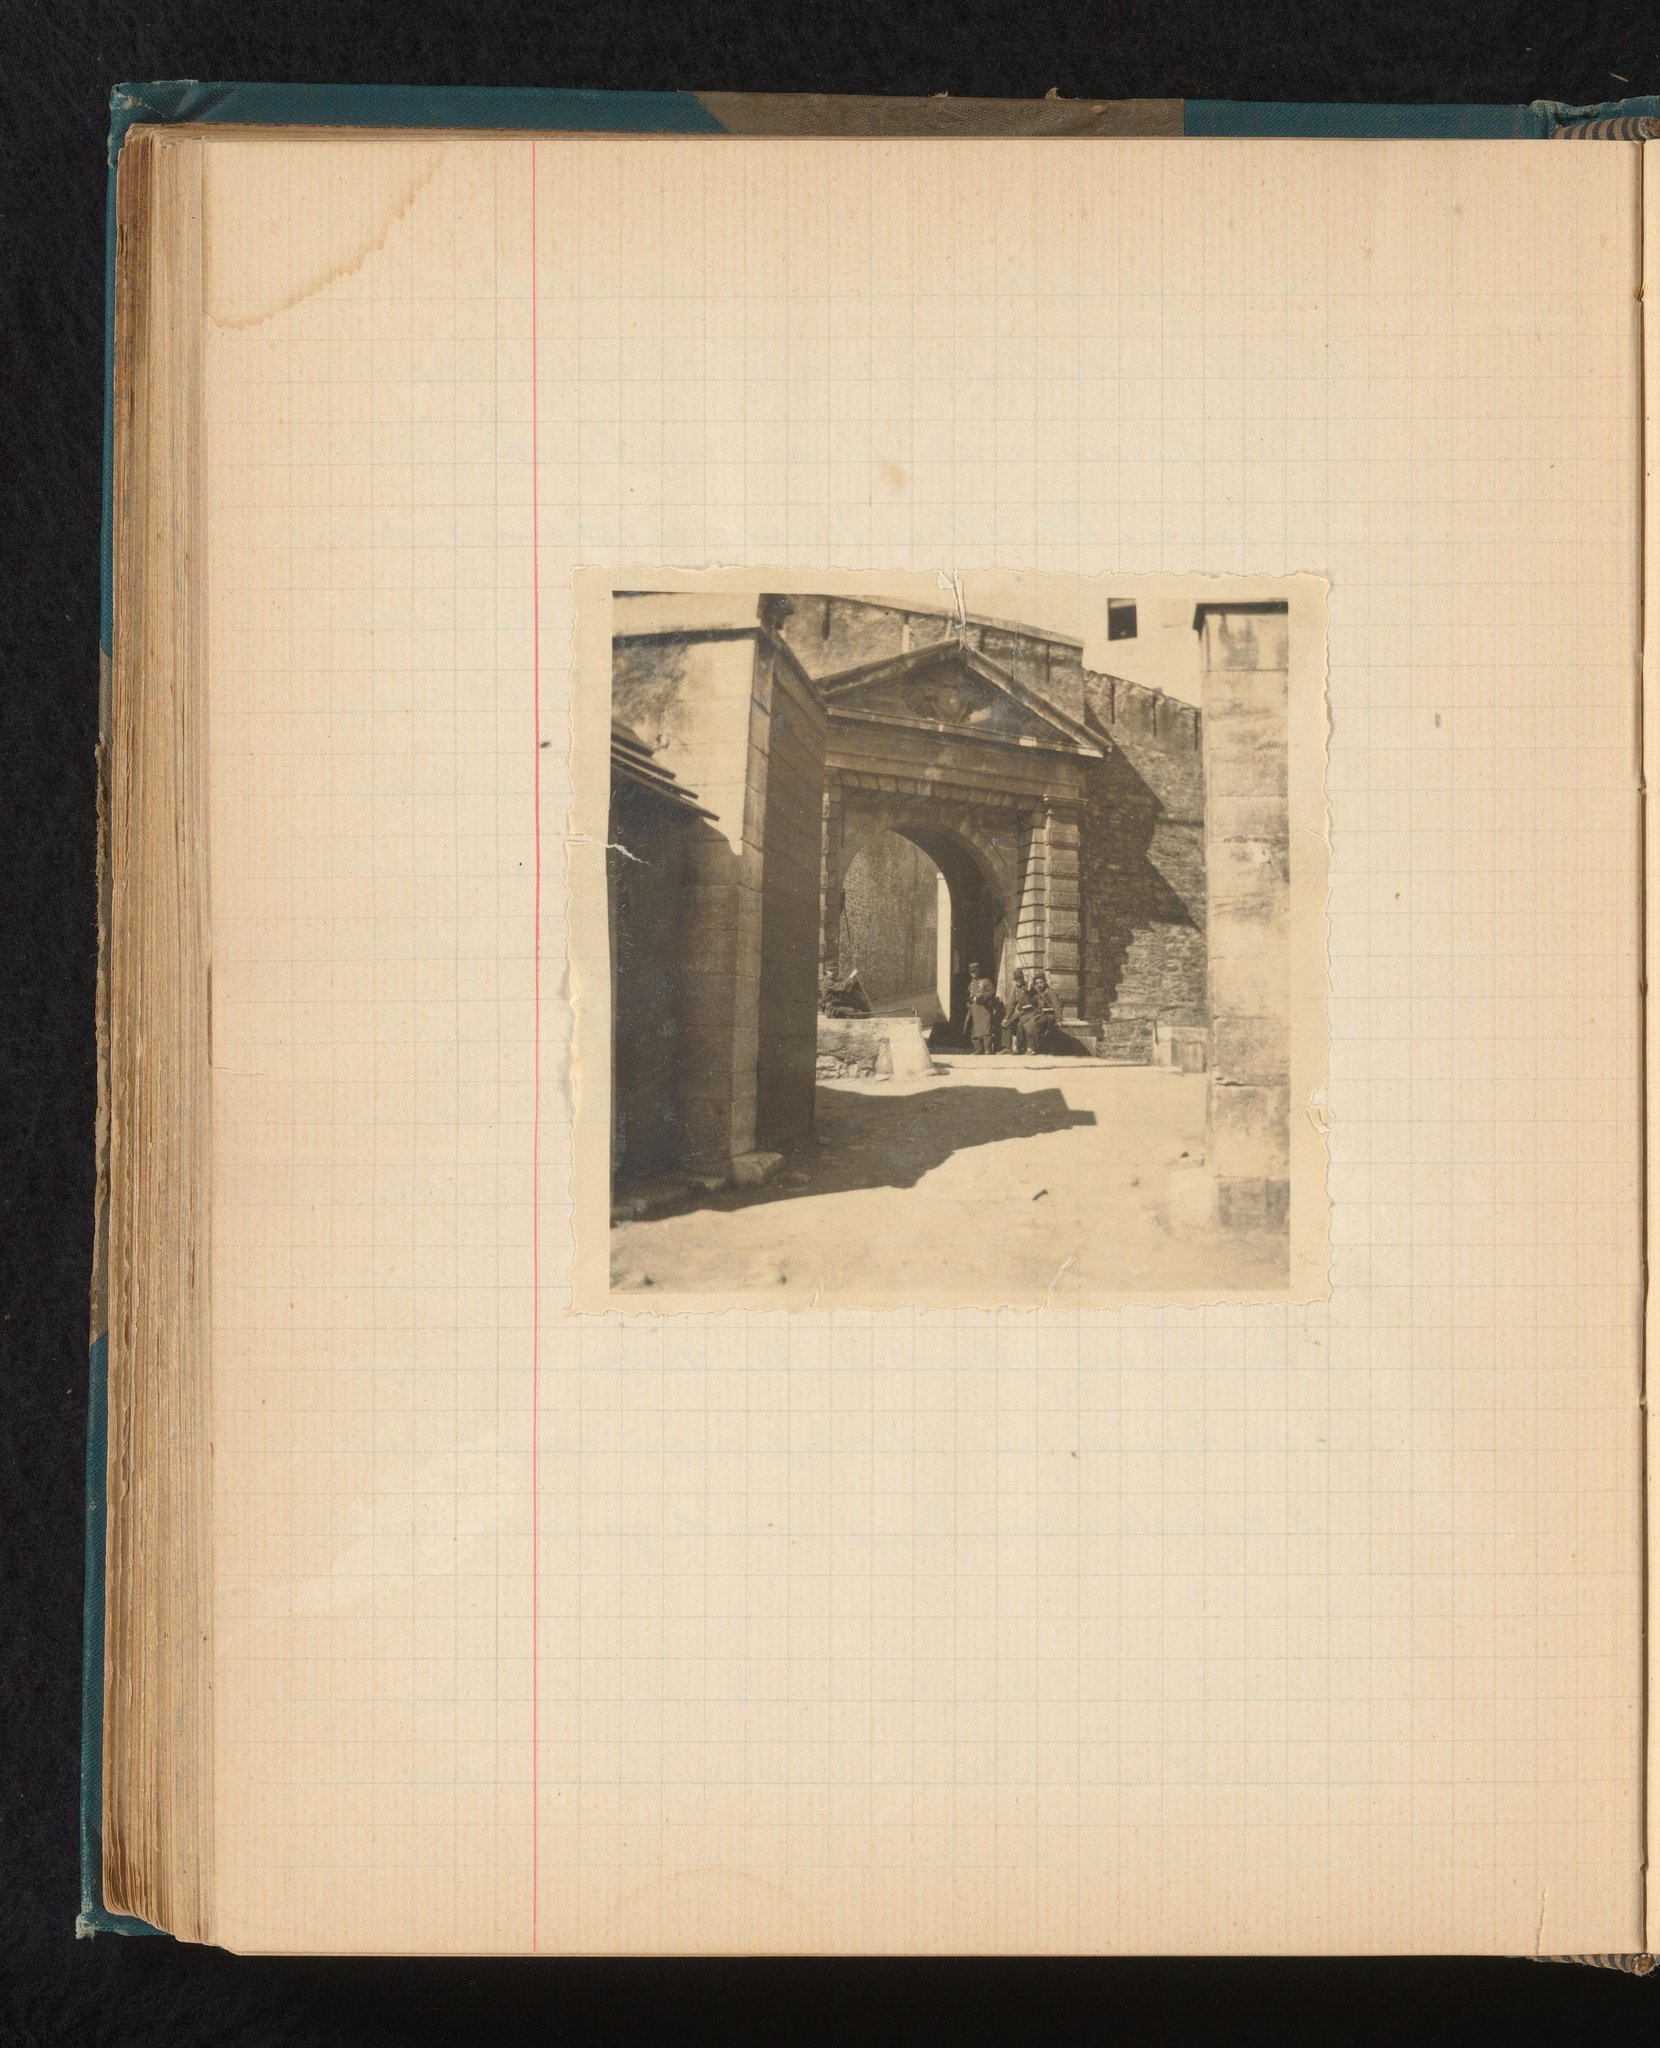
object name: album leaf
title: Oude poort met wachters eronder, mogelijk in Bastia, Corsica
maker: théodore van lelyveld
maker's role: painter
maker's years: 1867-1954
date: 1902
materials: paper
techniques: gelatin silver print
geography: corsica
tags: gate ~ fortified city, guard duty, keeping sentry